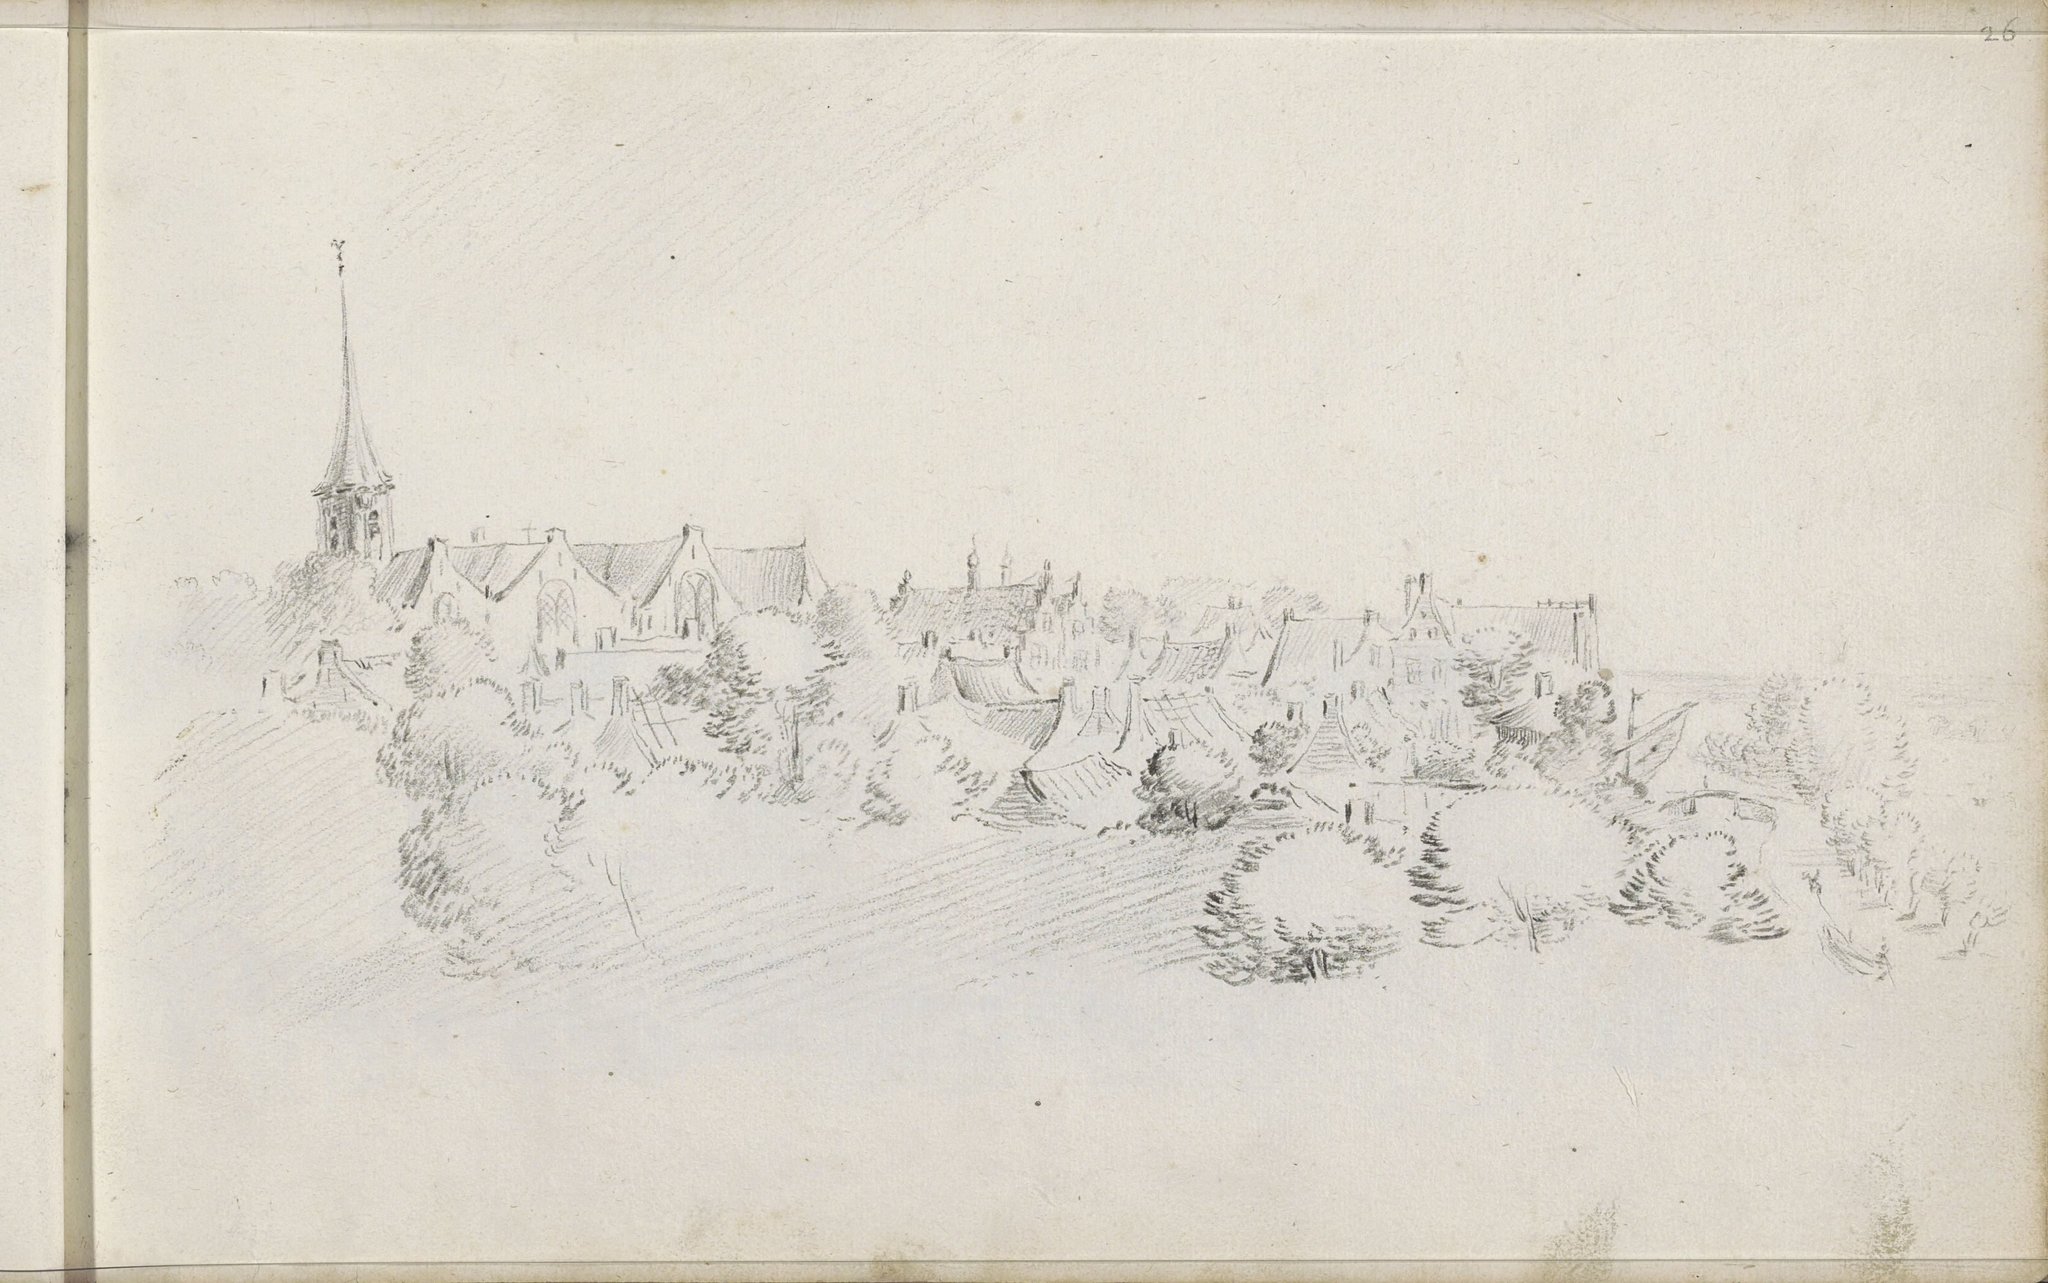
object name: sketchbook leaf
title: Gezicht op een stad, mogelijk Den Haag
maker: pieter moninckx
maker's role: draughtsman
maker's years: 1606-1686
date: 1645-1646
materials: chalk, paper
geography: the hague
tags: prospect of city, town panorama, silhouette of city, the hague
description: Blad 26 recto uit een schetsboek met 39 bladen.